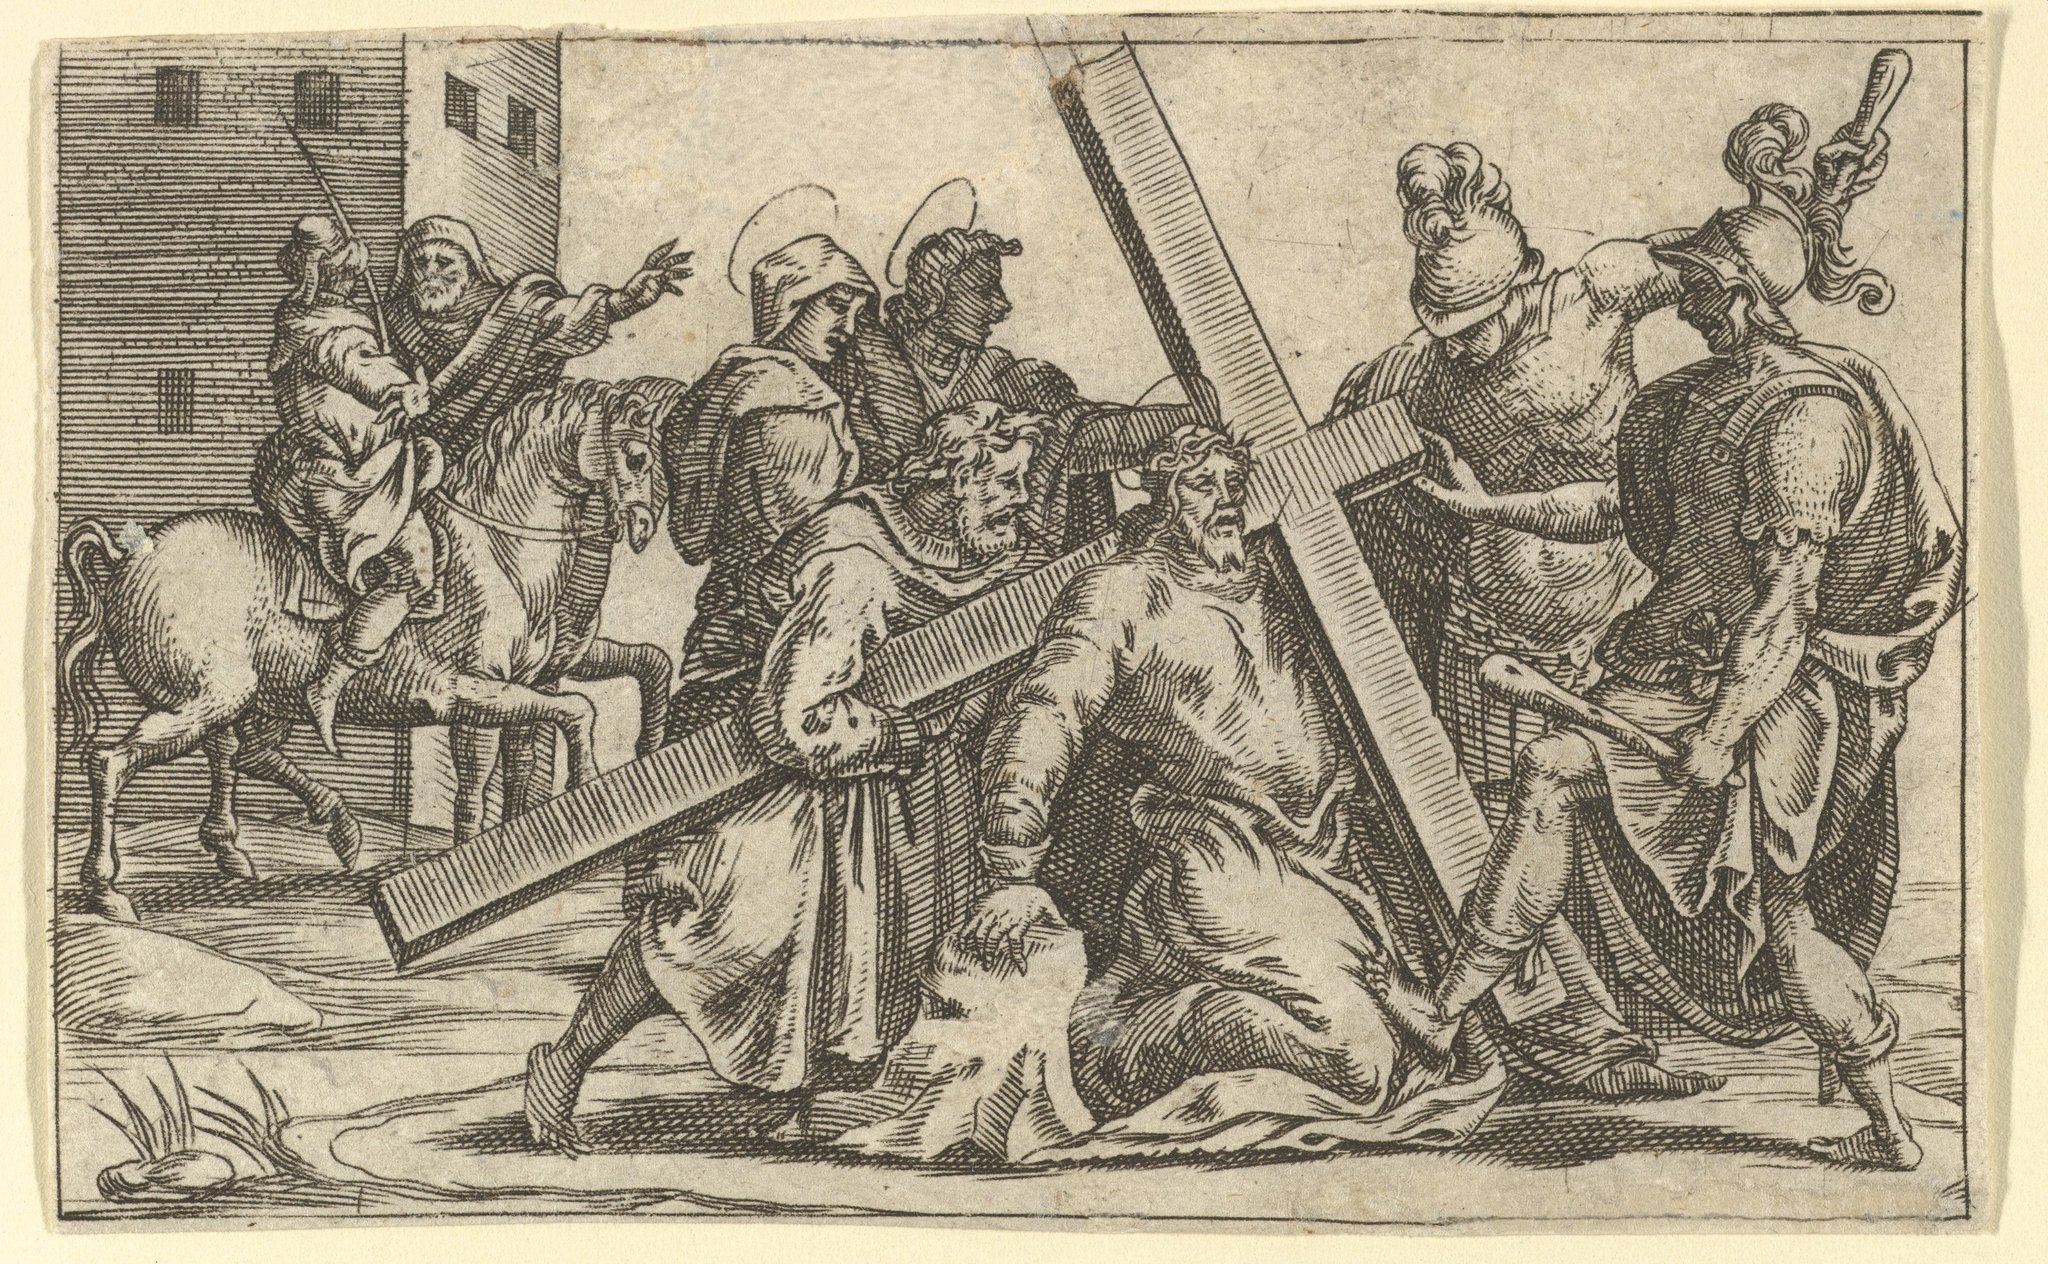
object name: print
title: The Virgin of Sorrows: Christ Bearing the Cross; one of nine surrounding compartments from the Virgin of Sorrows, now separated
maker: giorgio ghisi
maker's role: artist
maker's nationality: italian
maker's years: 1515-1582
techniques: engraving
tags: men,horses,christ,cross